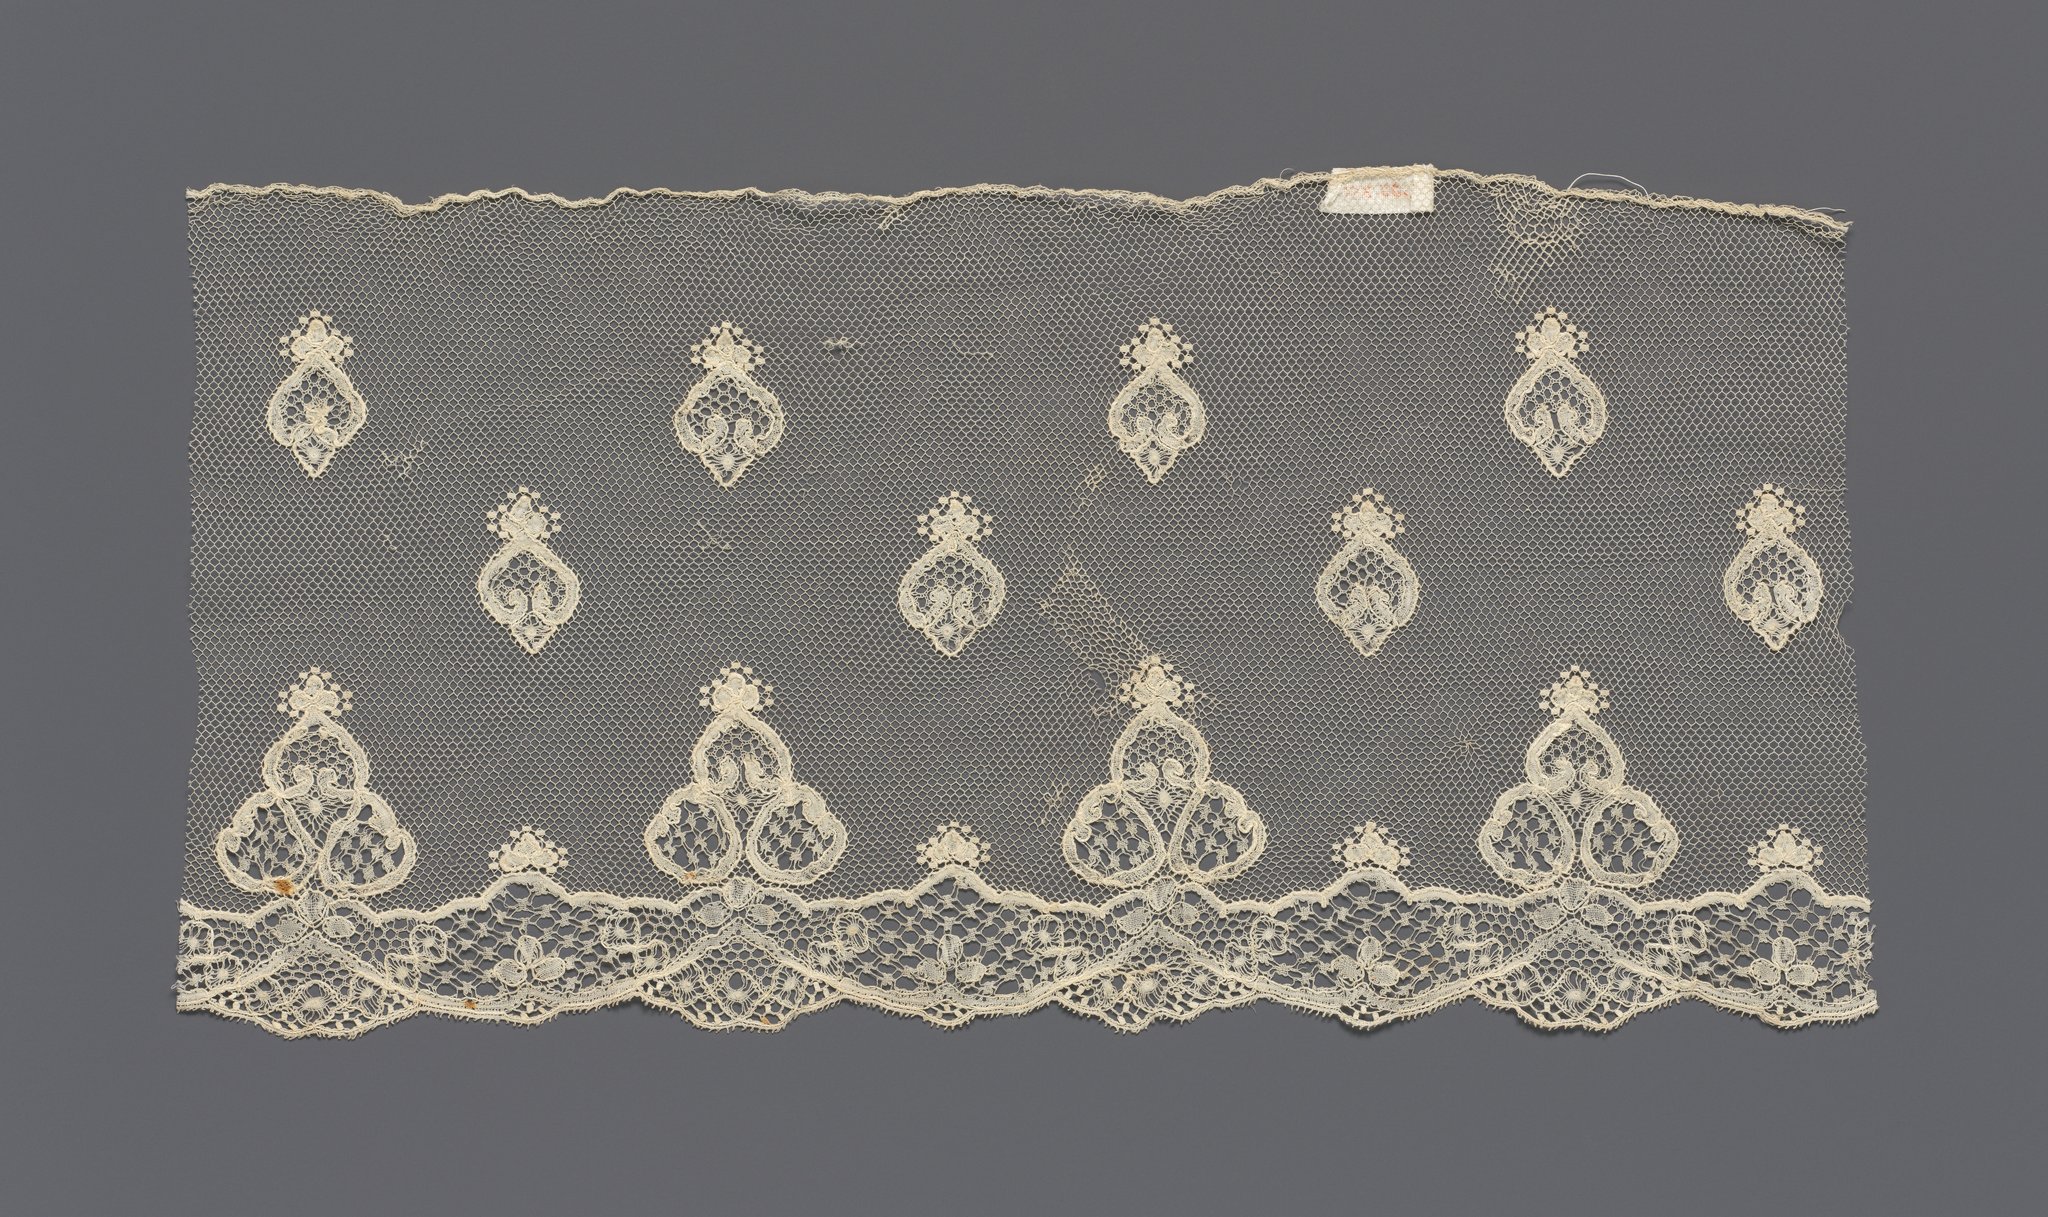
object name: edging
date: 1801-1833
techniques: lace